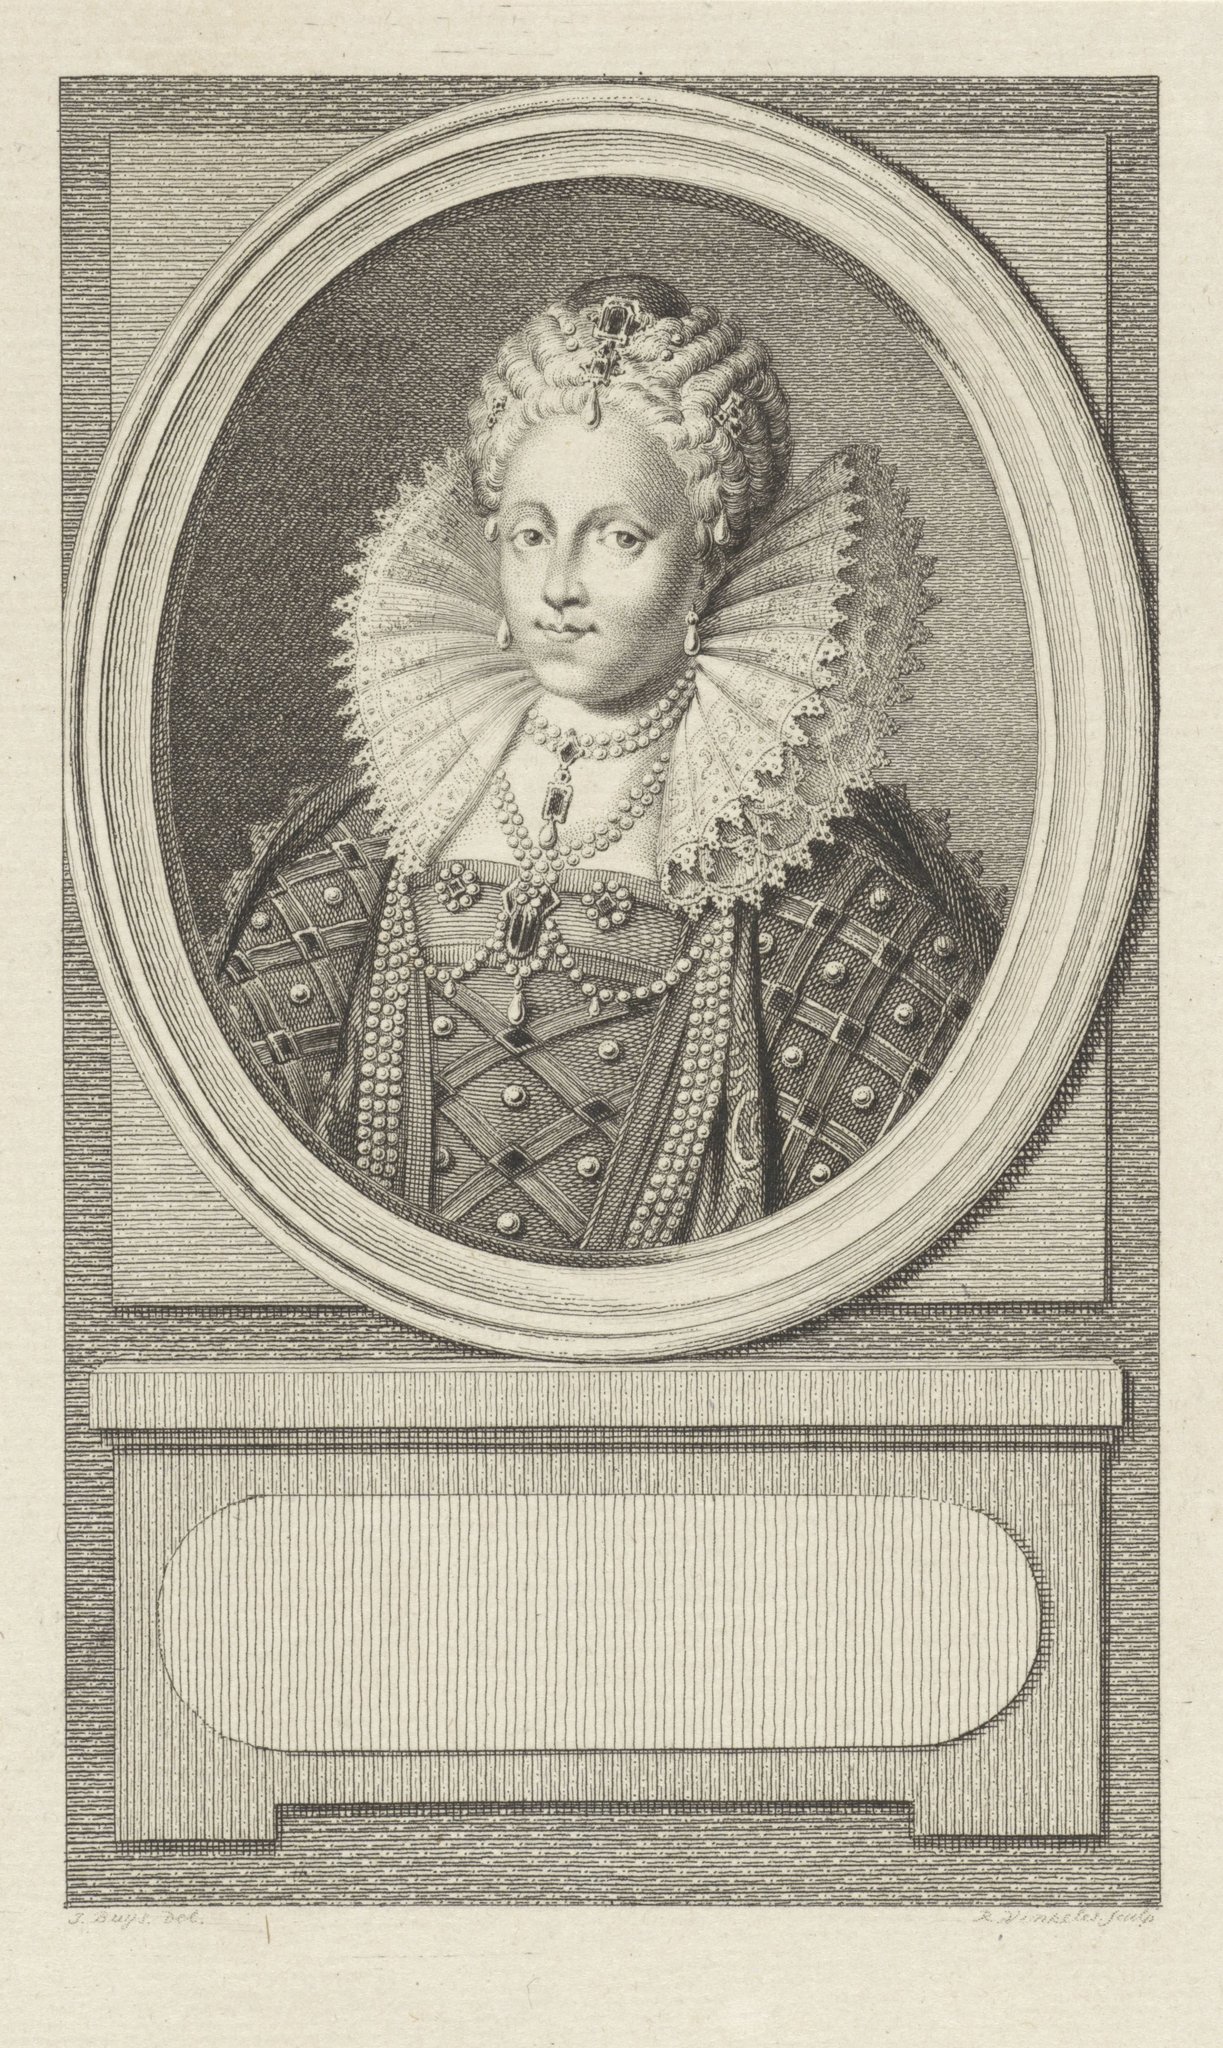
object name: print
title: Portret van Elizabeth I Tudor, koningin van Engeland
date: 1785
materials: paper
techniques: etching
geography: amsterdam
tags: greenwich, richmond (surrey), koningin, elizabeth i tudor (koningin van engeland)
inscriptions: collector's mark: Lugt 2228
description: Latere staat prent gebruikt als boekillustratie in: Kok, Jacobus. Vaderlandsch woordenboek : met kaarten, plaaten en pourtraitten. Amsterdam: Johannes Allart, 1785-1796. Deel XIII.